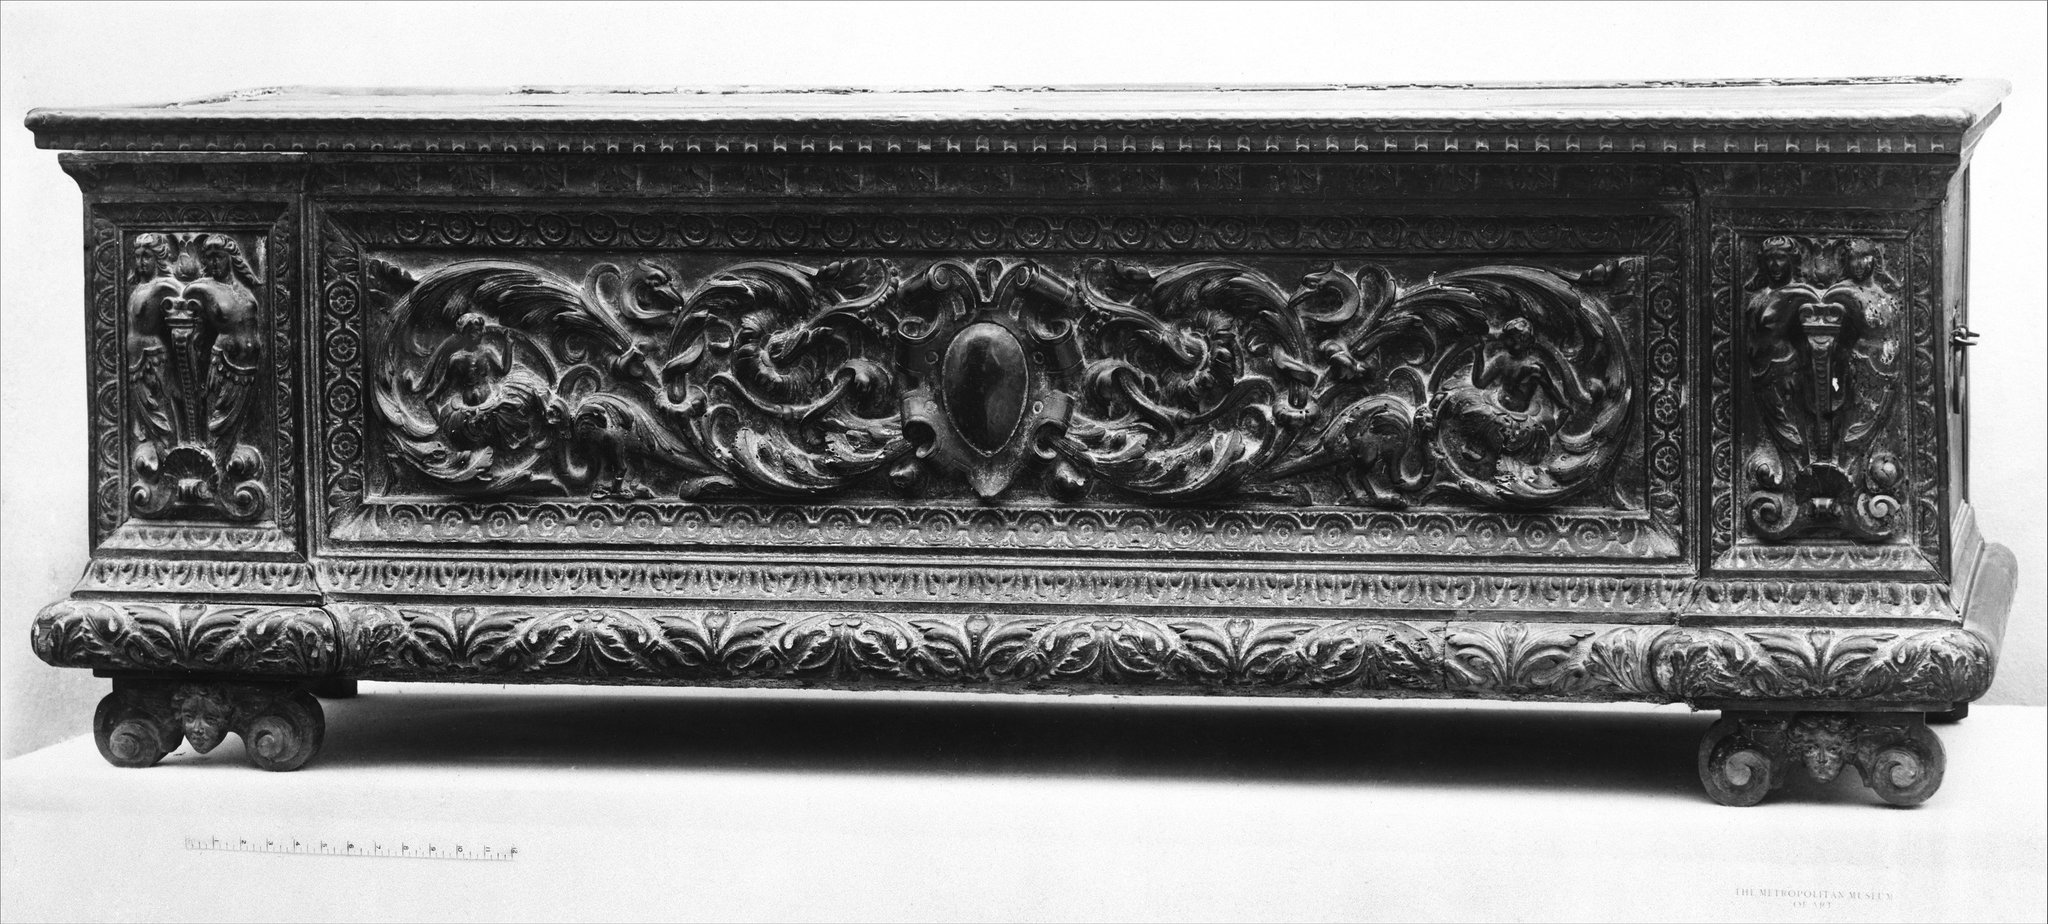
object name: cassone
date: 1551-1600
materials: wood